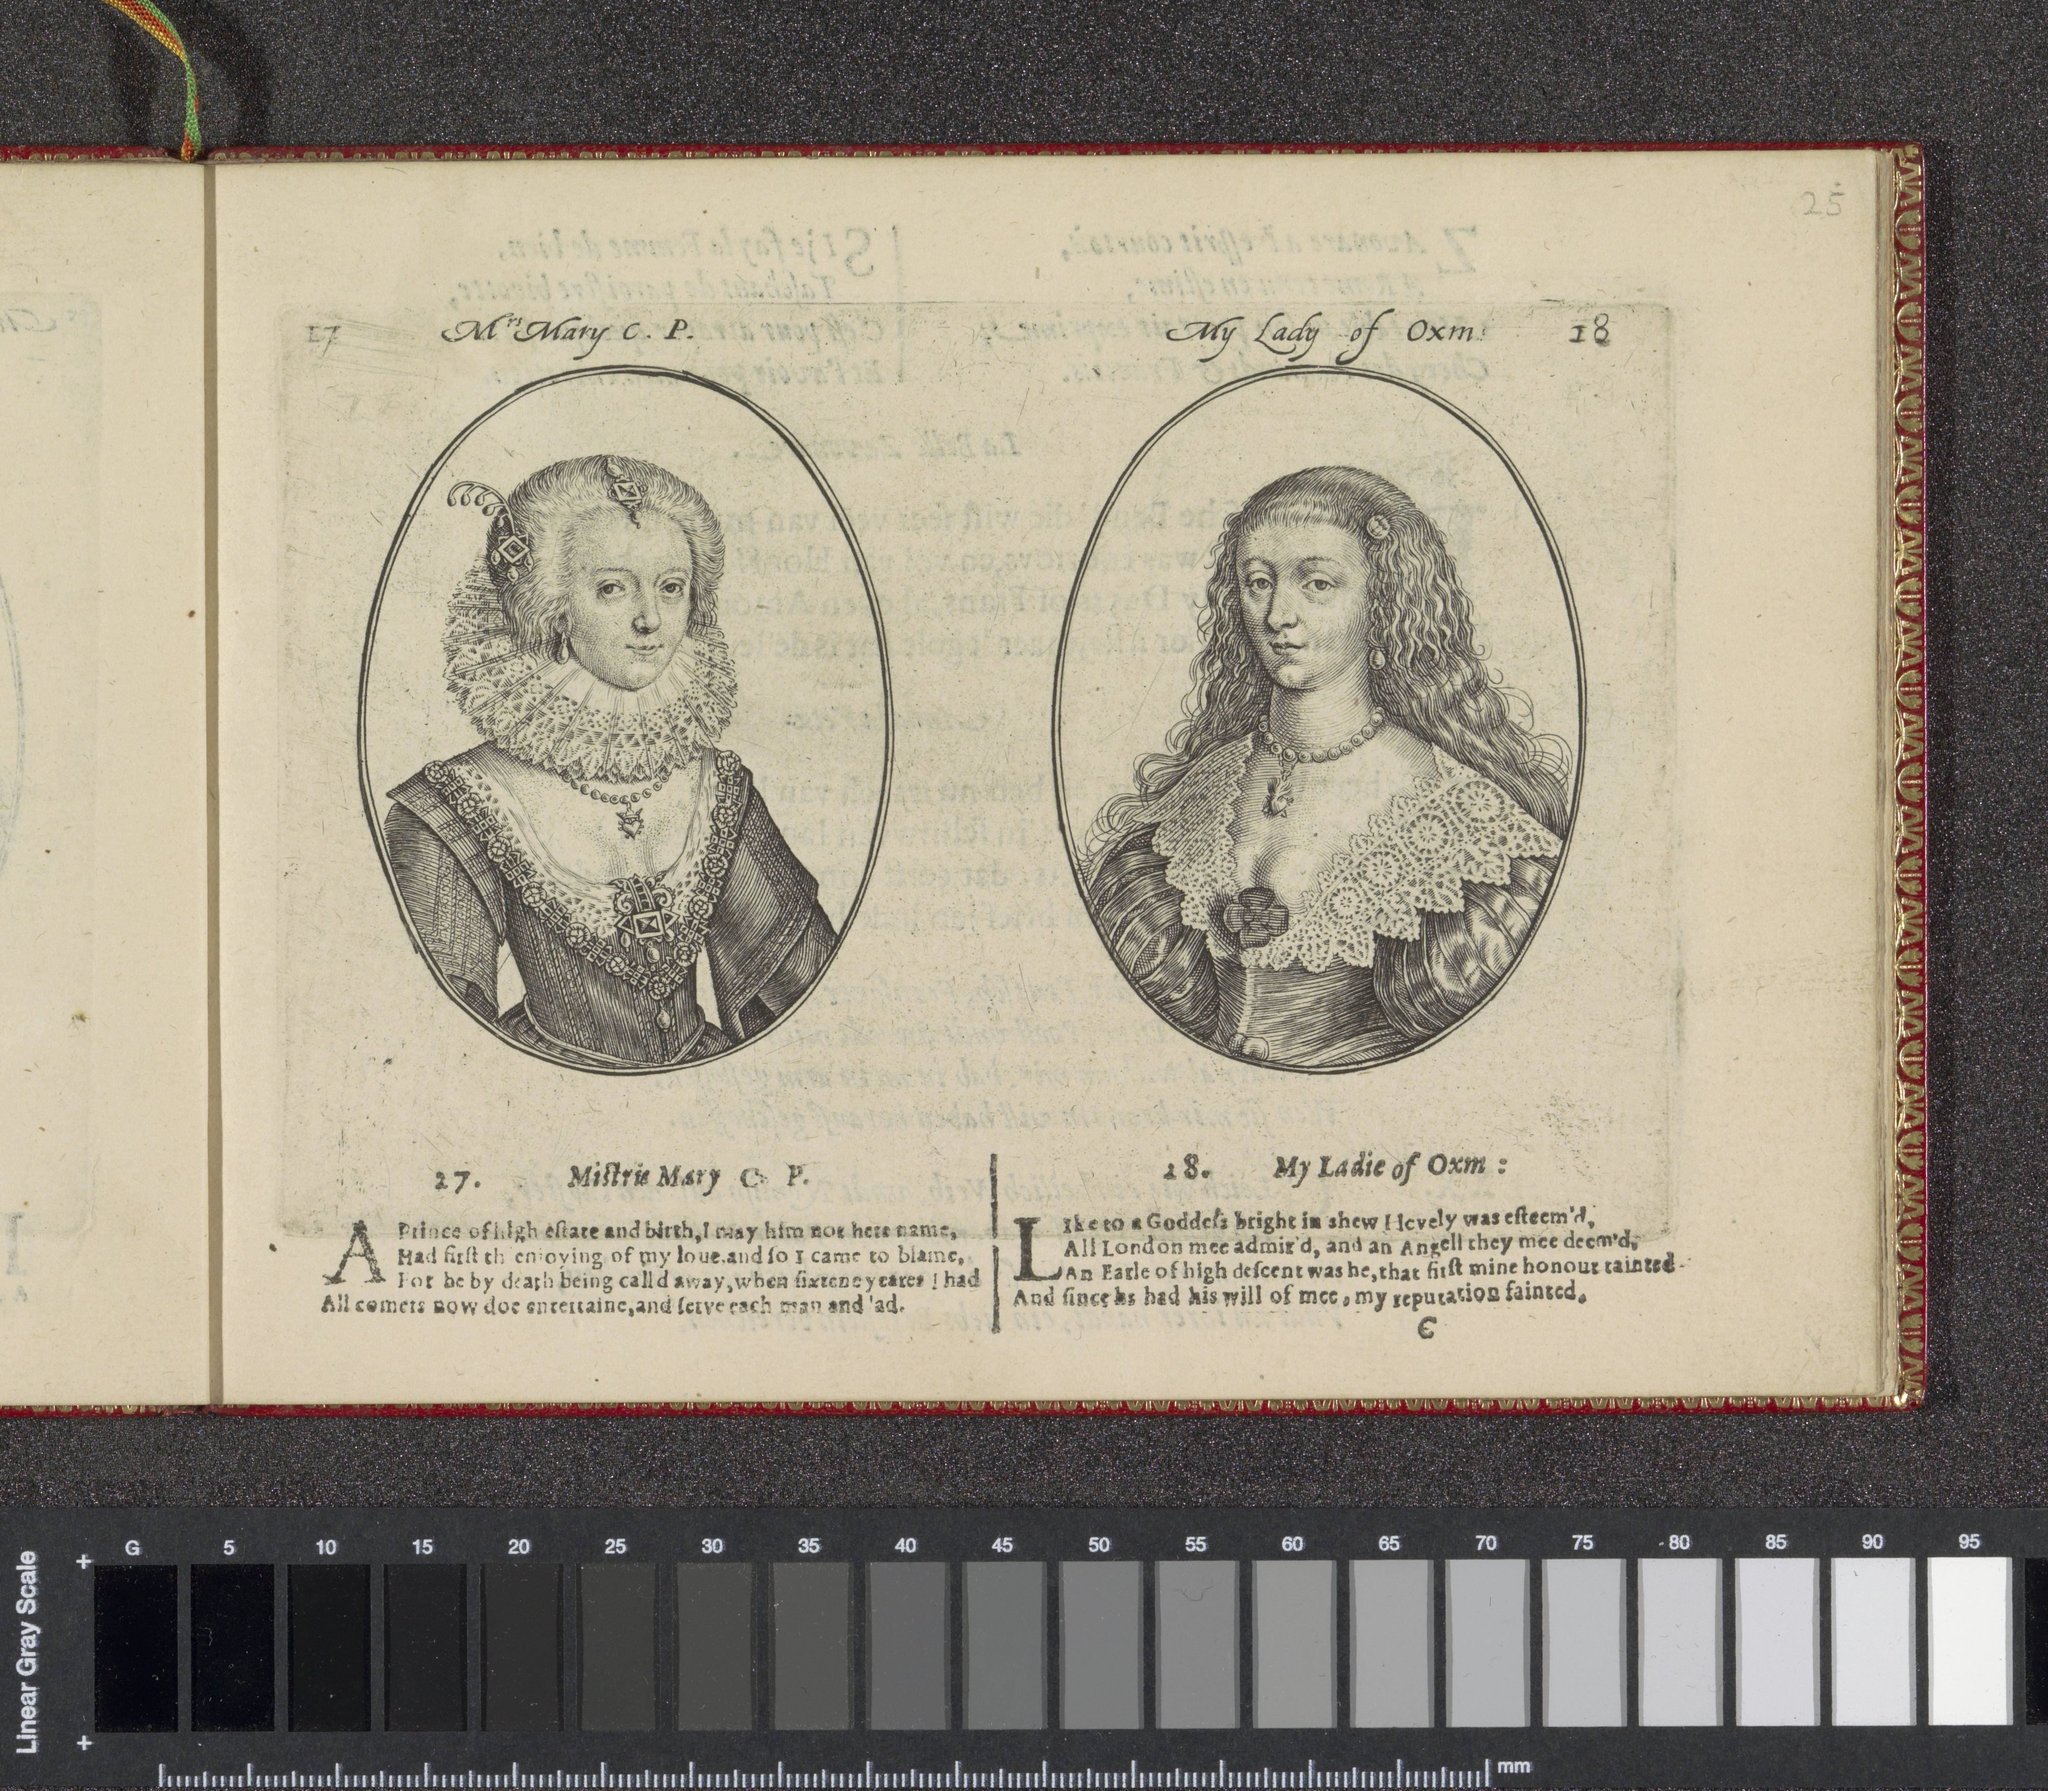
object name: print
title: Miroir des plus belles courtisanes de ce temps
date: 1635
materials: paper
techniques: engraving, letterpress printing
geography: utrecht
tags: herding, herdsman, herdswoman, shepherd, shepherdess, cowherd, etc.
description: Twee voorstellingen op een albumblad. Links de courtisane Mary C.P. en rechts Lady of Oxm., afkomstig uit Londen. Daaronder twee kwatrijnen in het Engels. Het blad maakt deel uit van een album.